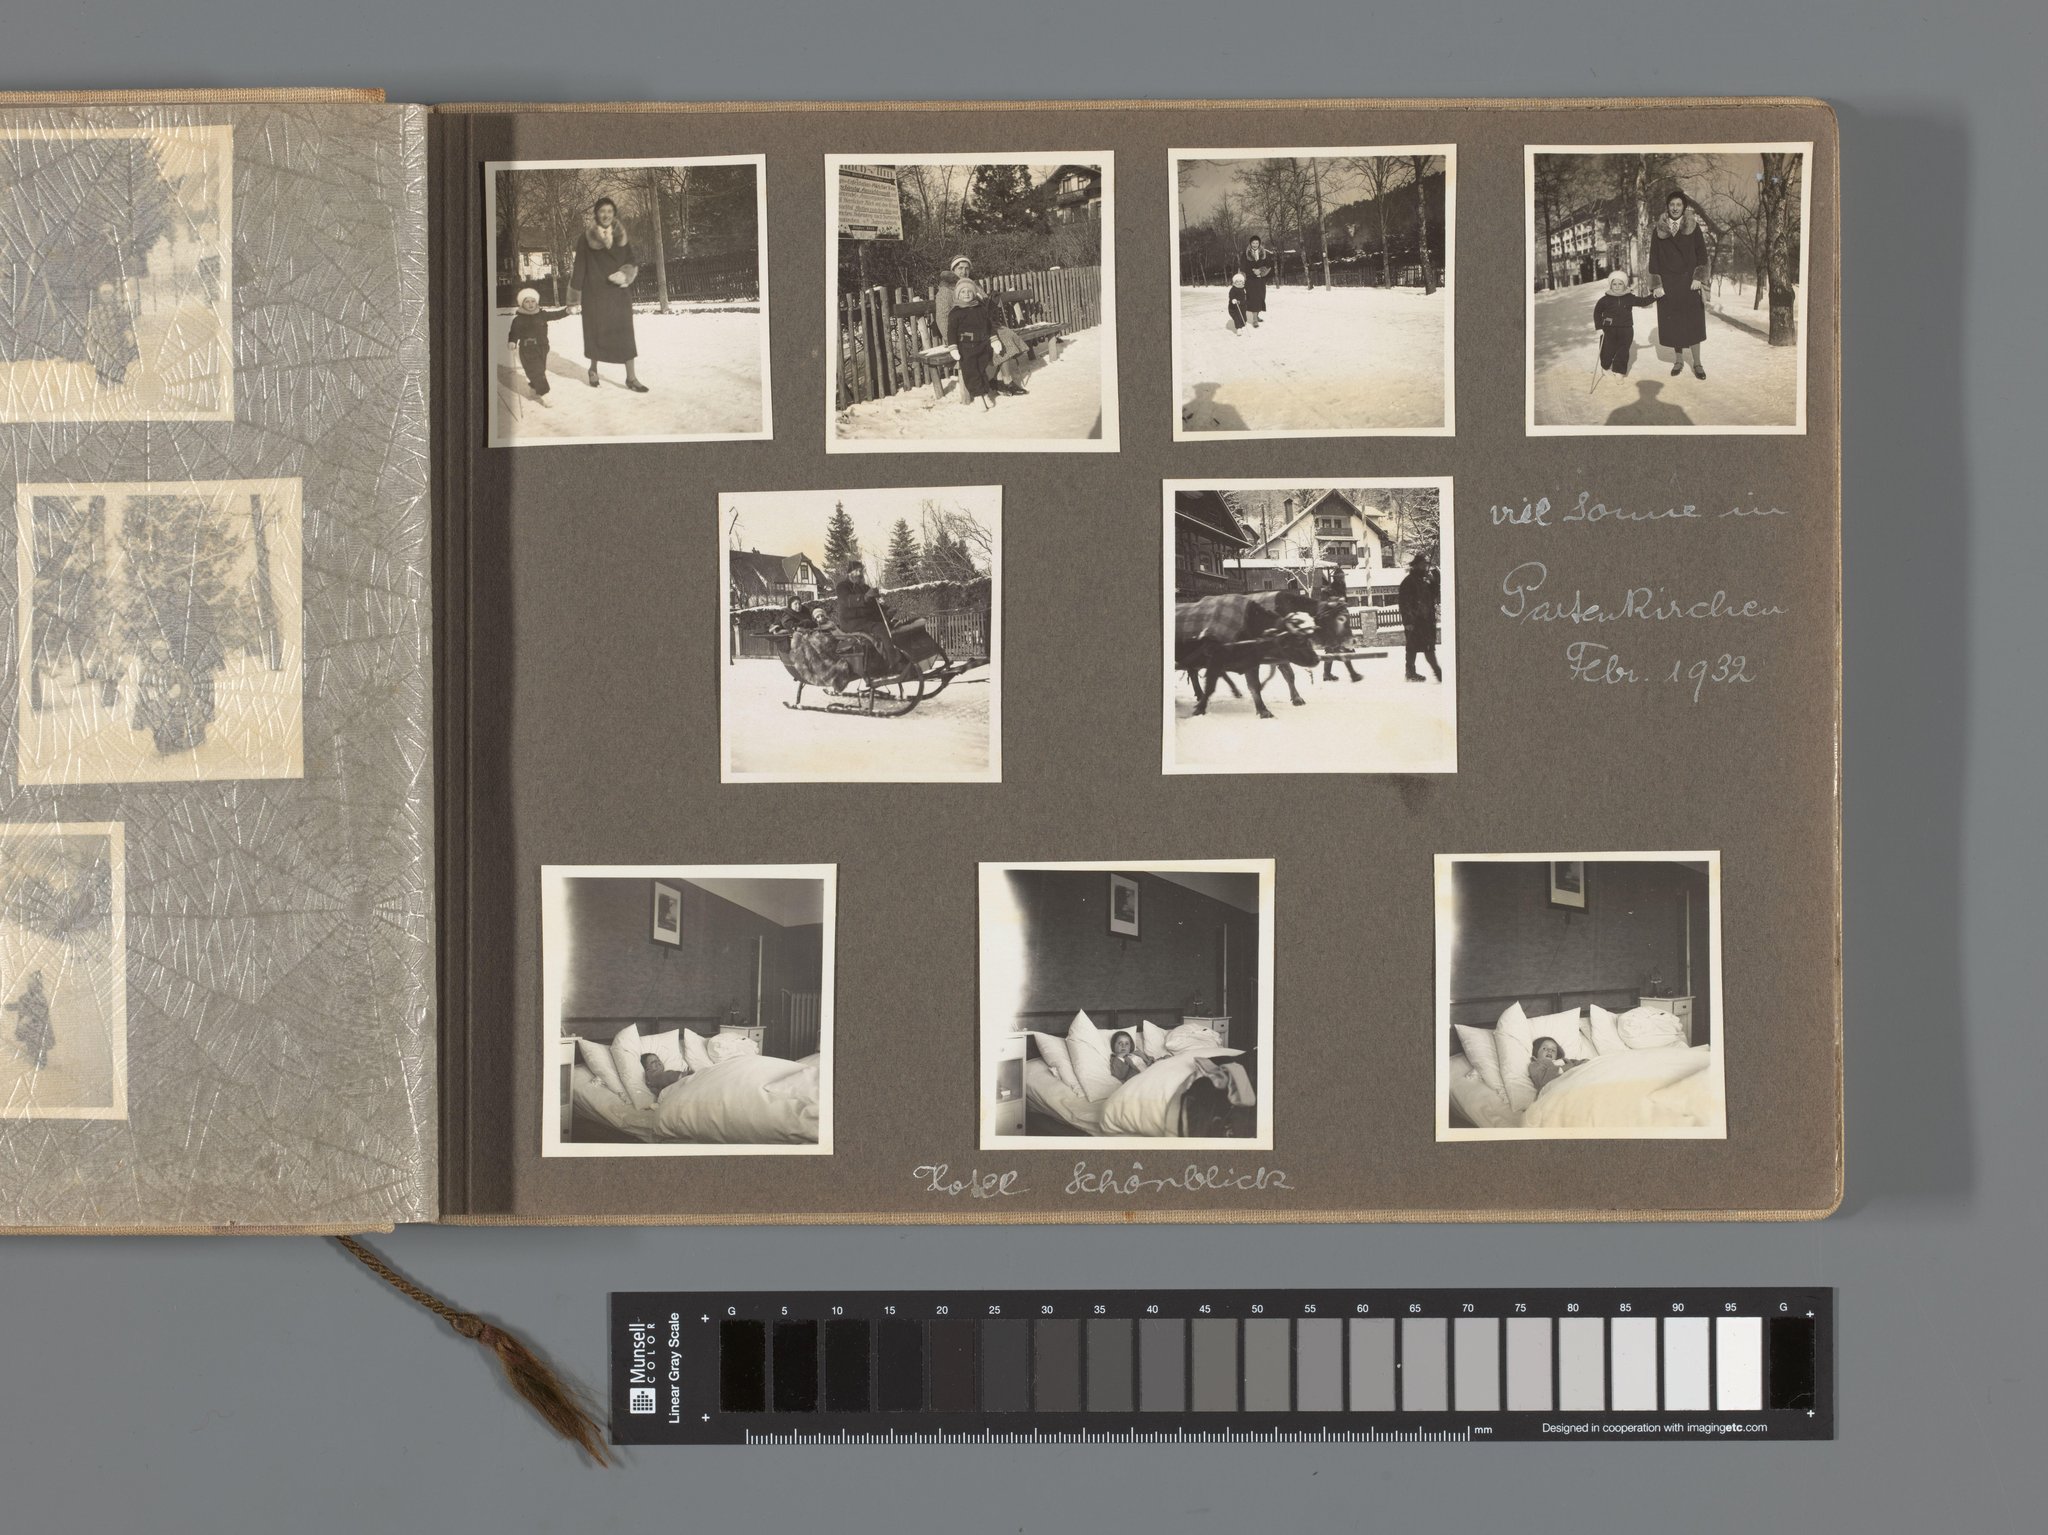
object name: photograph album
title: Photograph album of the Wachenheimer family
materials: textile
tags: eugen wachenheimer, else wachenheimer-moos, leiden, isabel wachenheimer-elon, willy moos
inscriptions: date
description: After her internment in Nazi concentration camps, Isabel Wachenheimer kept her camp jacket, as well as her family’s pre-war photograph albums. They contain seemingly everyday snapshots: the four-year old Isabel playing with a friend, and sitting on her father’s lap on 10 October 1932, her parent’s wedding anniversary. They were murdered in Auschwitz-Birkenau on 14 October 1944. Isabel died in Leiden on 10 October 2010.